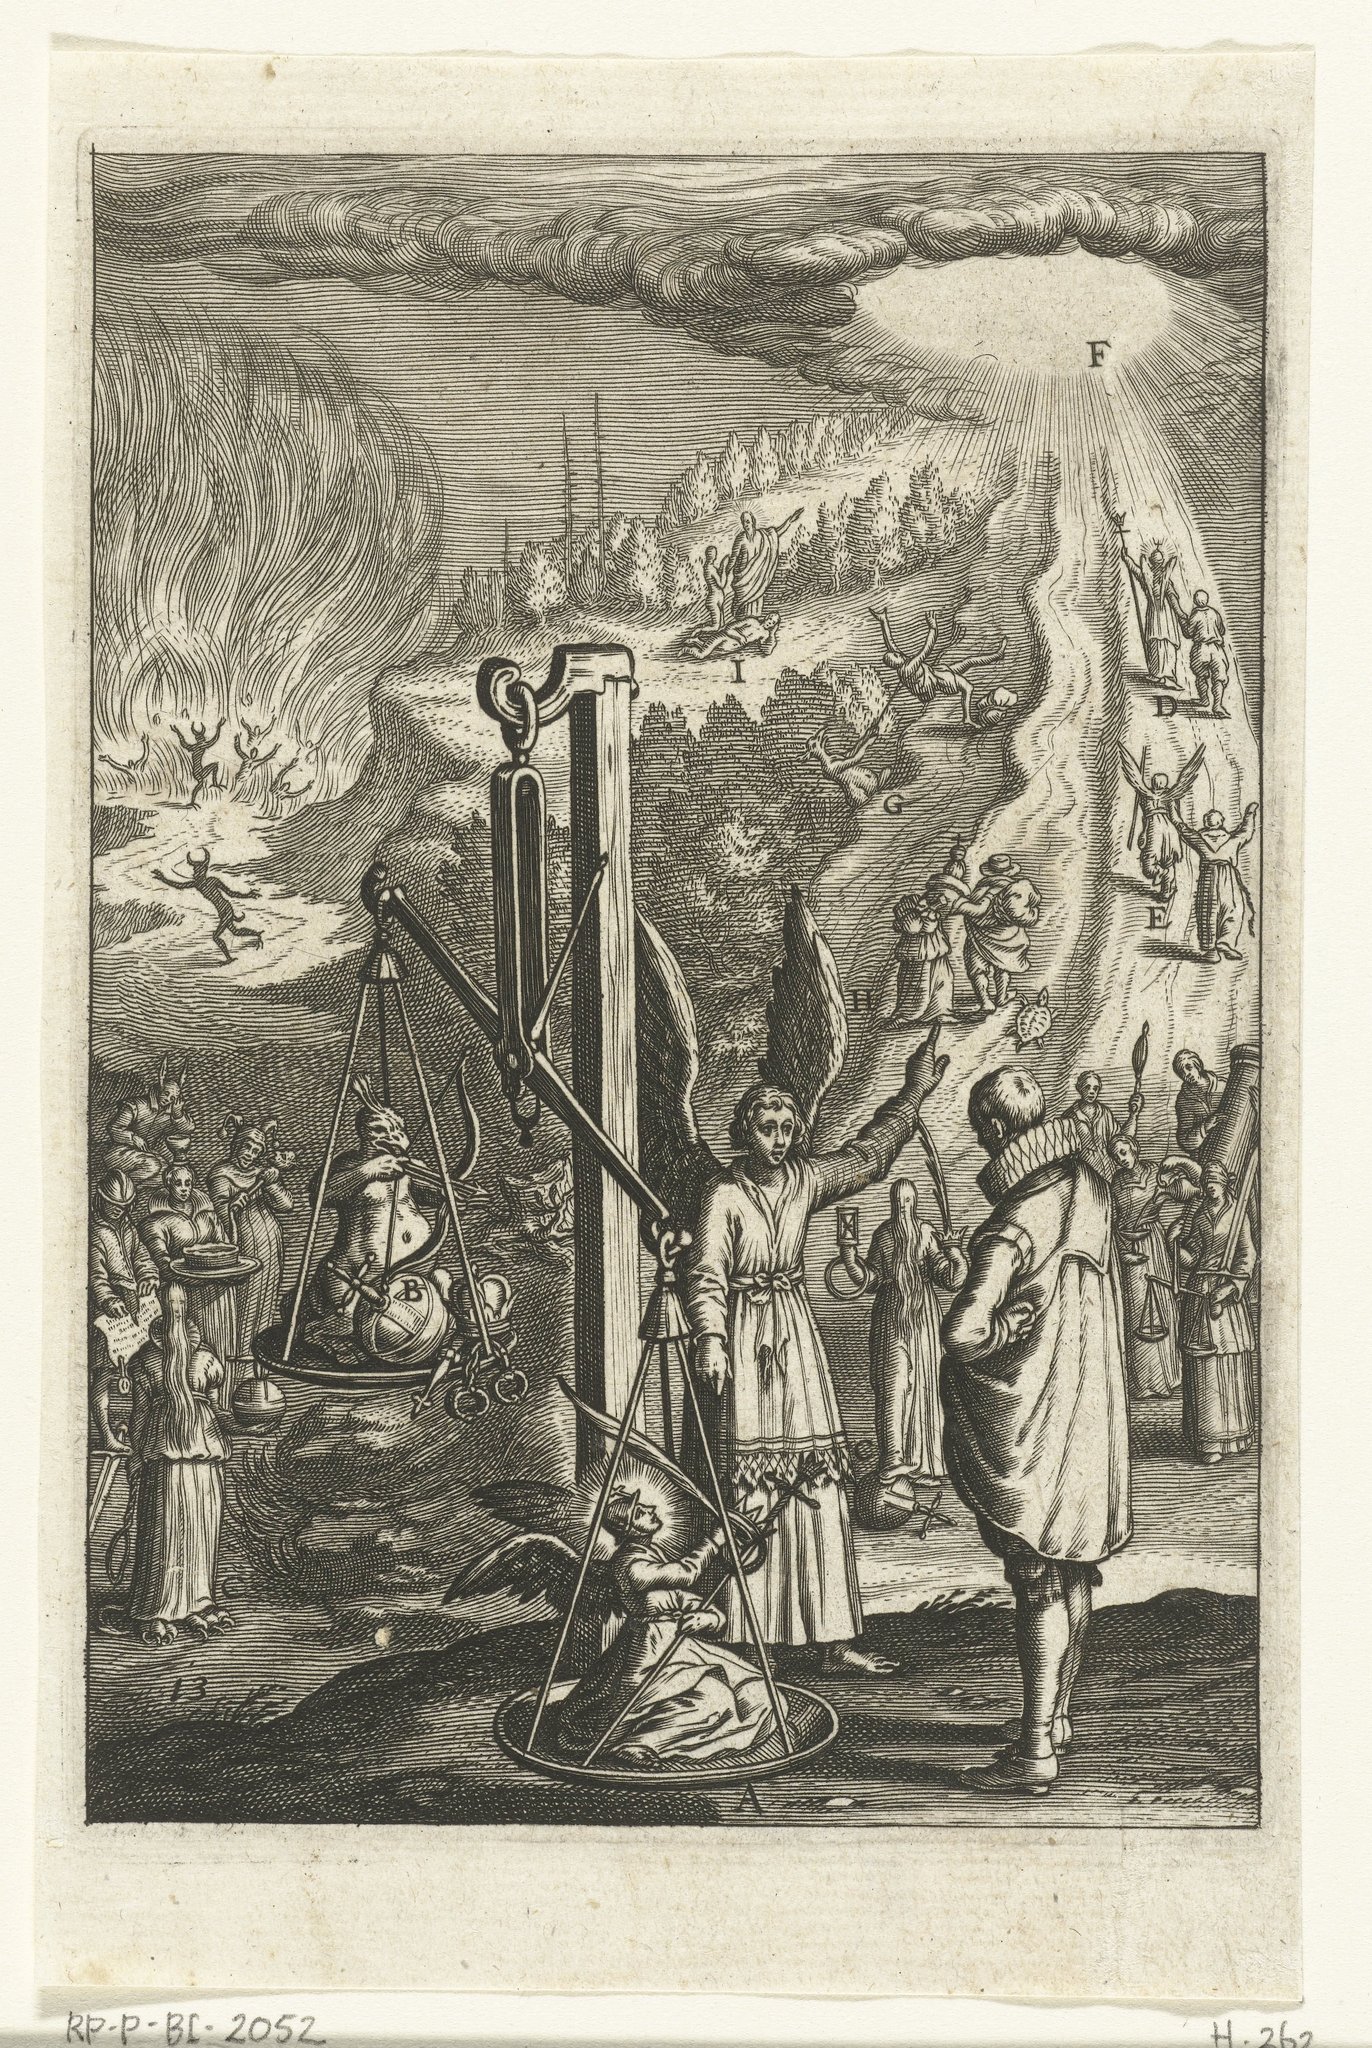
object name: print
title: Embleem met engel die man toont hoe hij deugd en zonde tegen elkaar af moet wegen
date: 1620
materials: paper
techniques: engraving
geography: antwerp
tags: the life of man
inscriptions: collector's mark: Lugt 2228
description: Een engel staat bij een weegschaal en toont een man hoeveel zwaarder de deugd weegt dan de zonde. Op de ene schaal zit de duivel met de wereldbol en tekenen van macht, hij wordt te licht bevonden. De engel die wel gewicht in de schaal legt, staat voor de deugd. Het landschap achter hen toont wat de man staat te wachten bij zijn keuze.